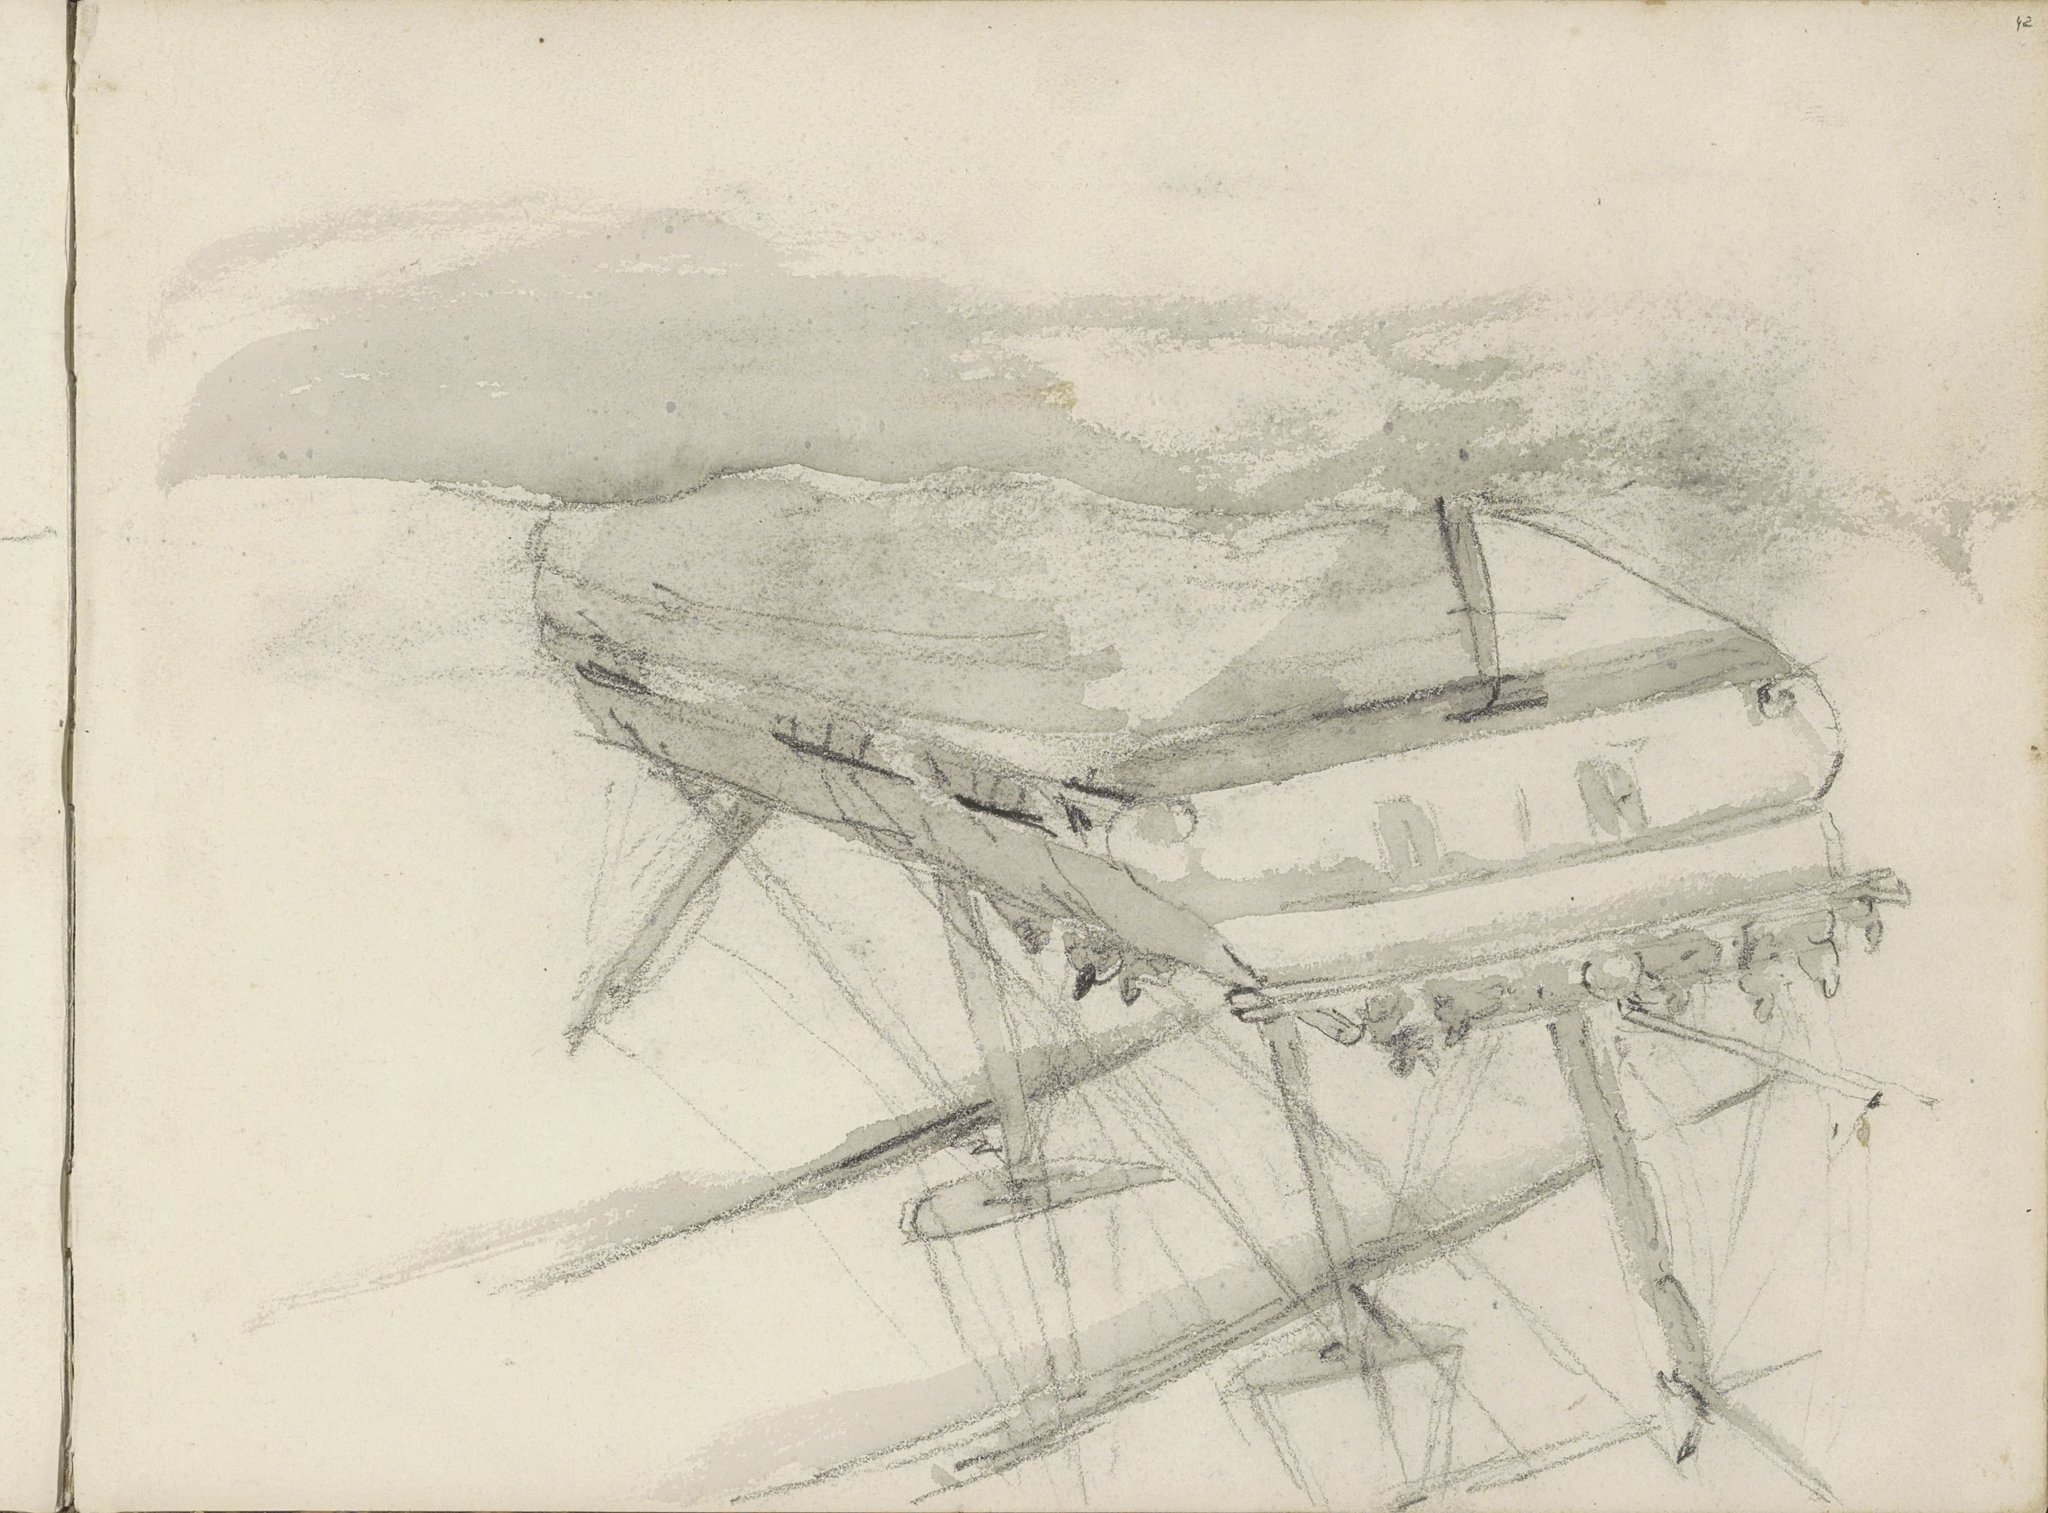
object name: sketchbook leaf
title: Driemaster op zee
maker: petrus johannes schotel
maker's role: draughtsman, painter, print maker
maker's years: 1808-1865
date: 1825-1875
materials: paper, pencil, watercolor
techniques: brush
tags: sailing-ship, sailing-boat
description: Blad 42 recto uit een schetsboek met 44 bladen.